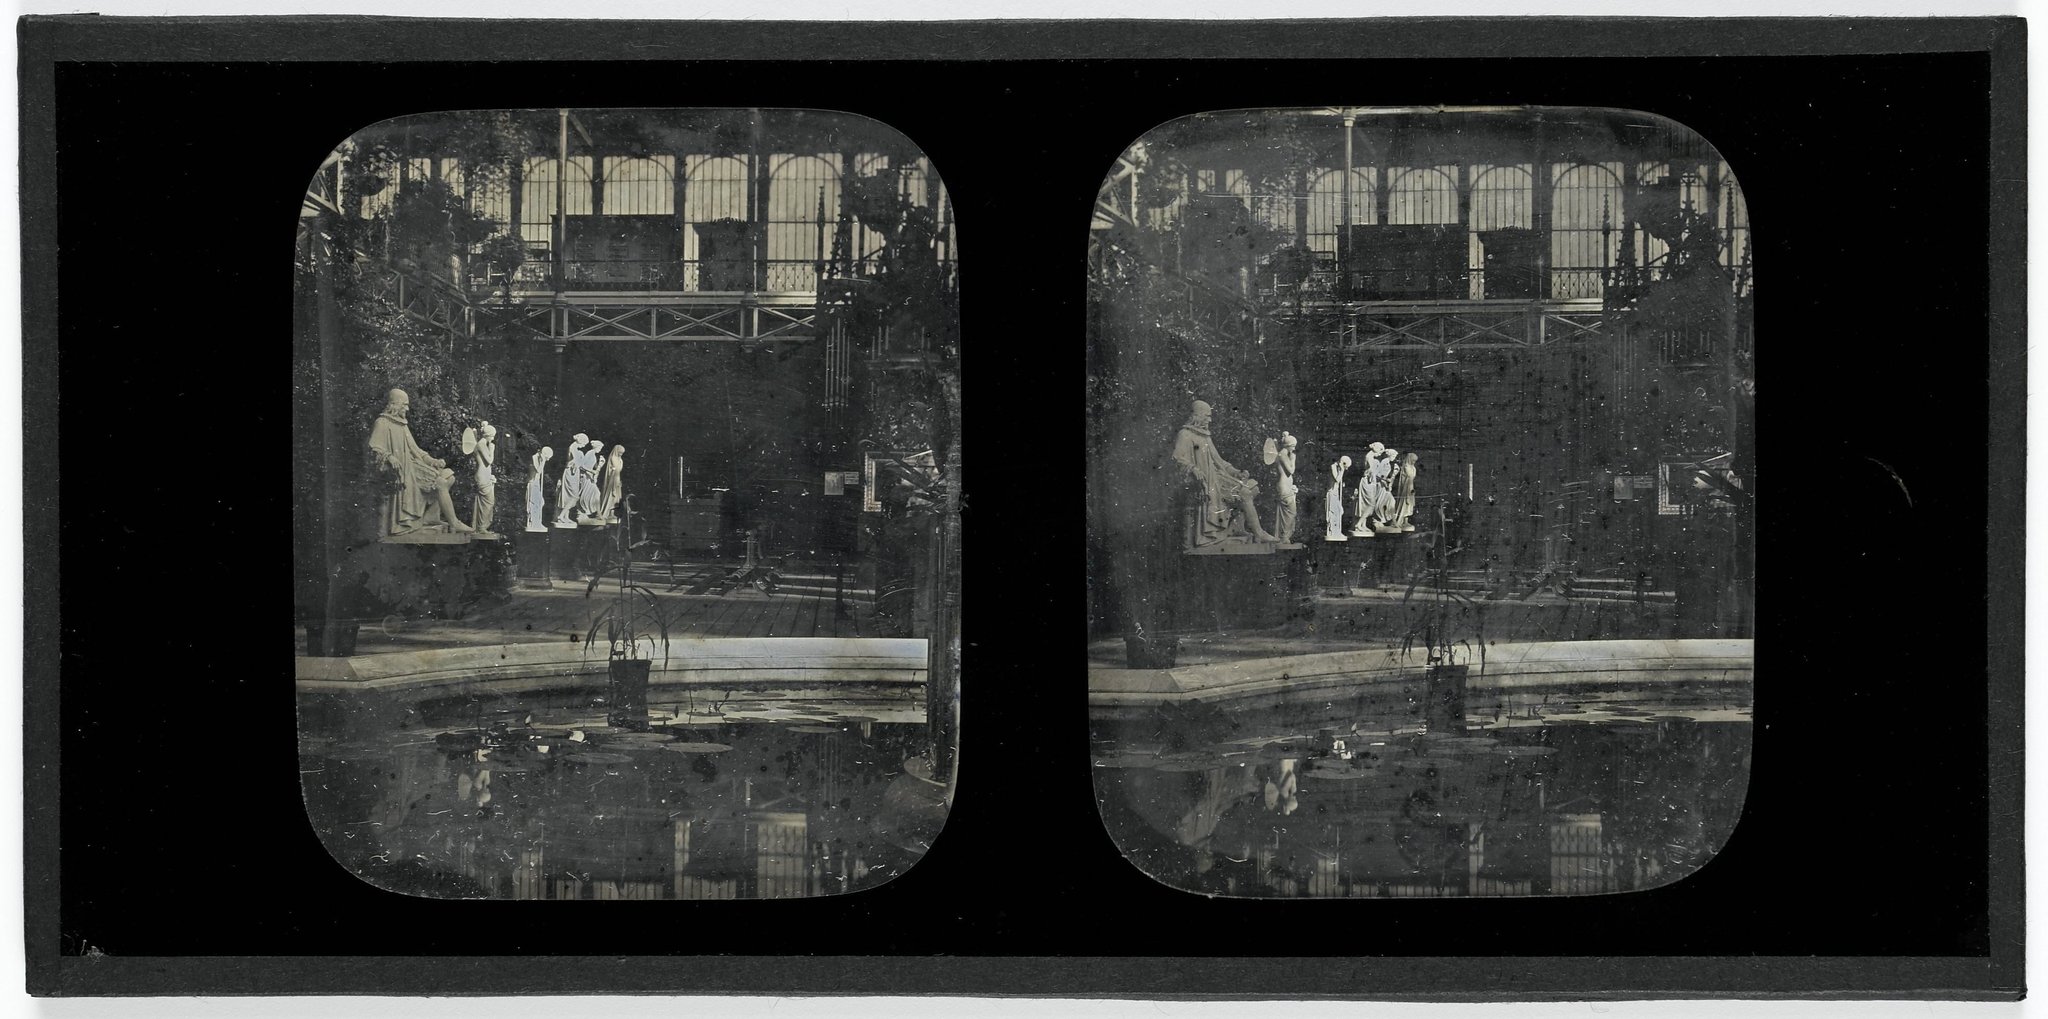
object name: stereograph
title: Interieur van het Crystal Palace te Sydenham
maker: Anonymous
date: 1854-1855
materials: copper, glass, paper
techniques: daguerreotype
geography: london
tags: collection, exhibition, show